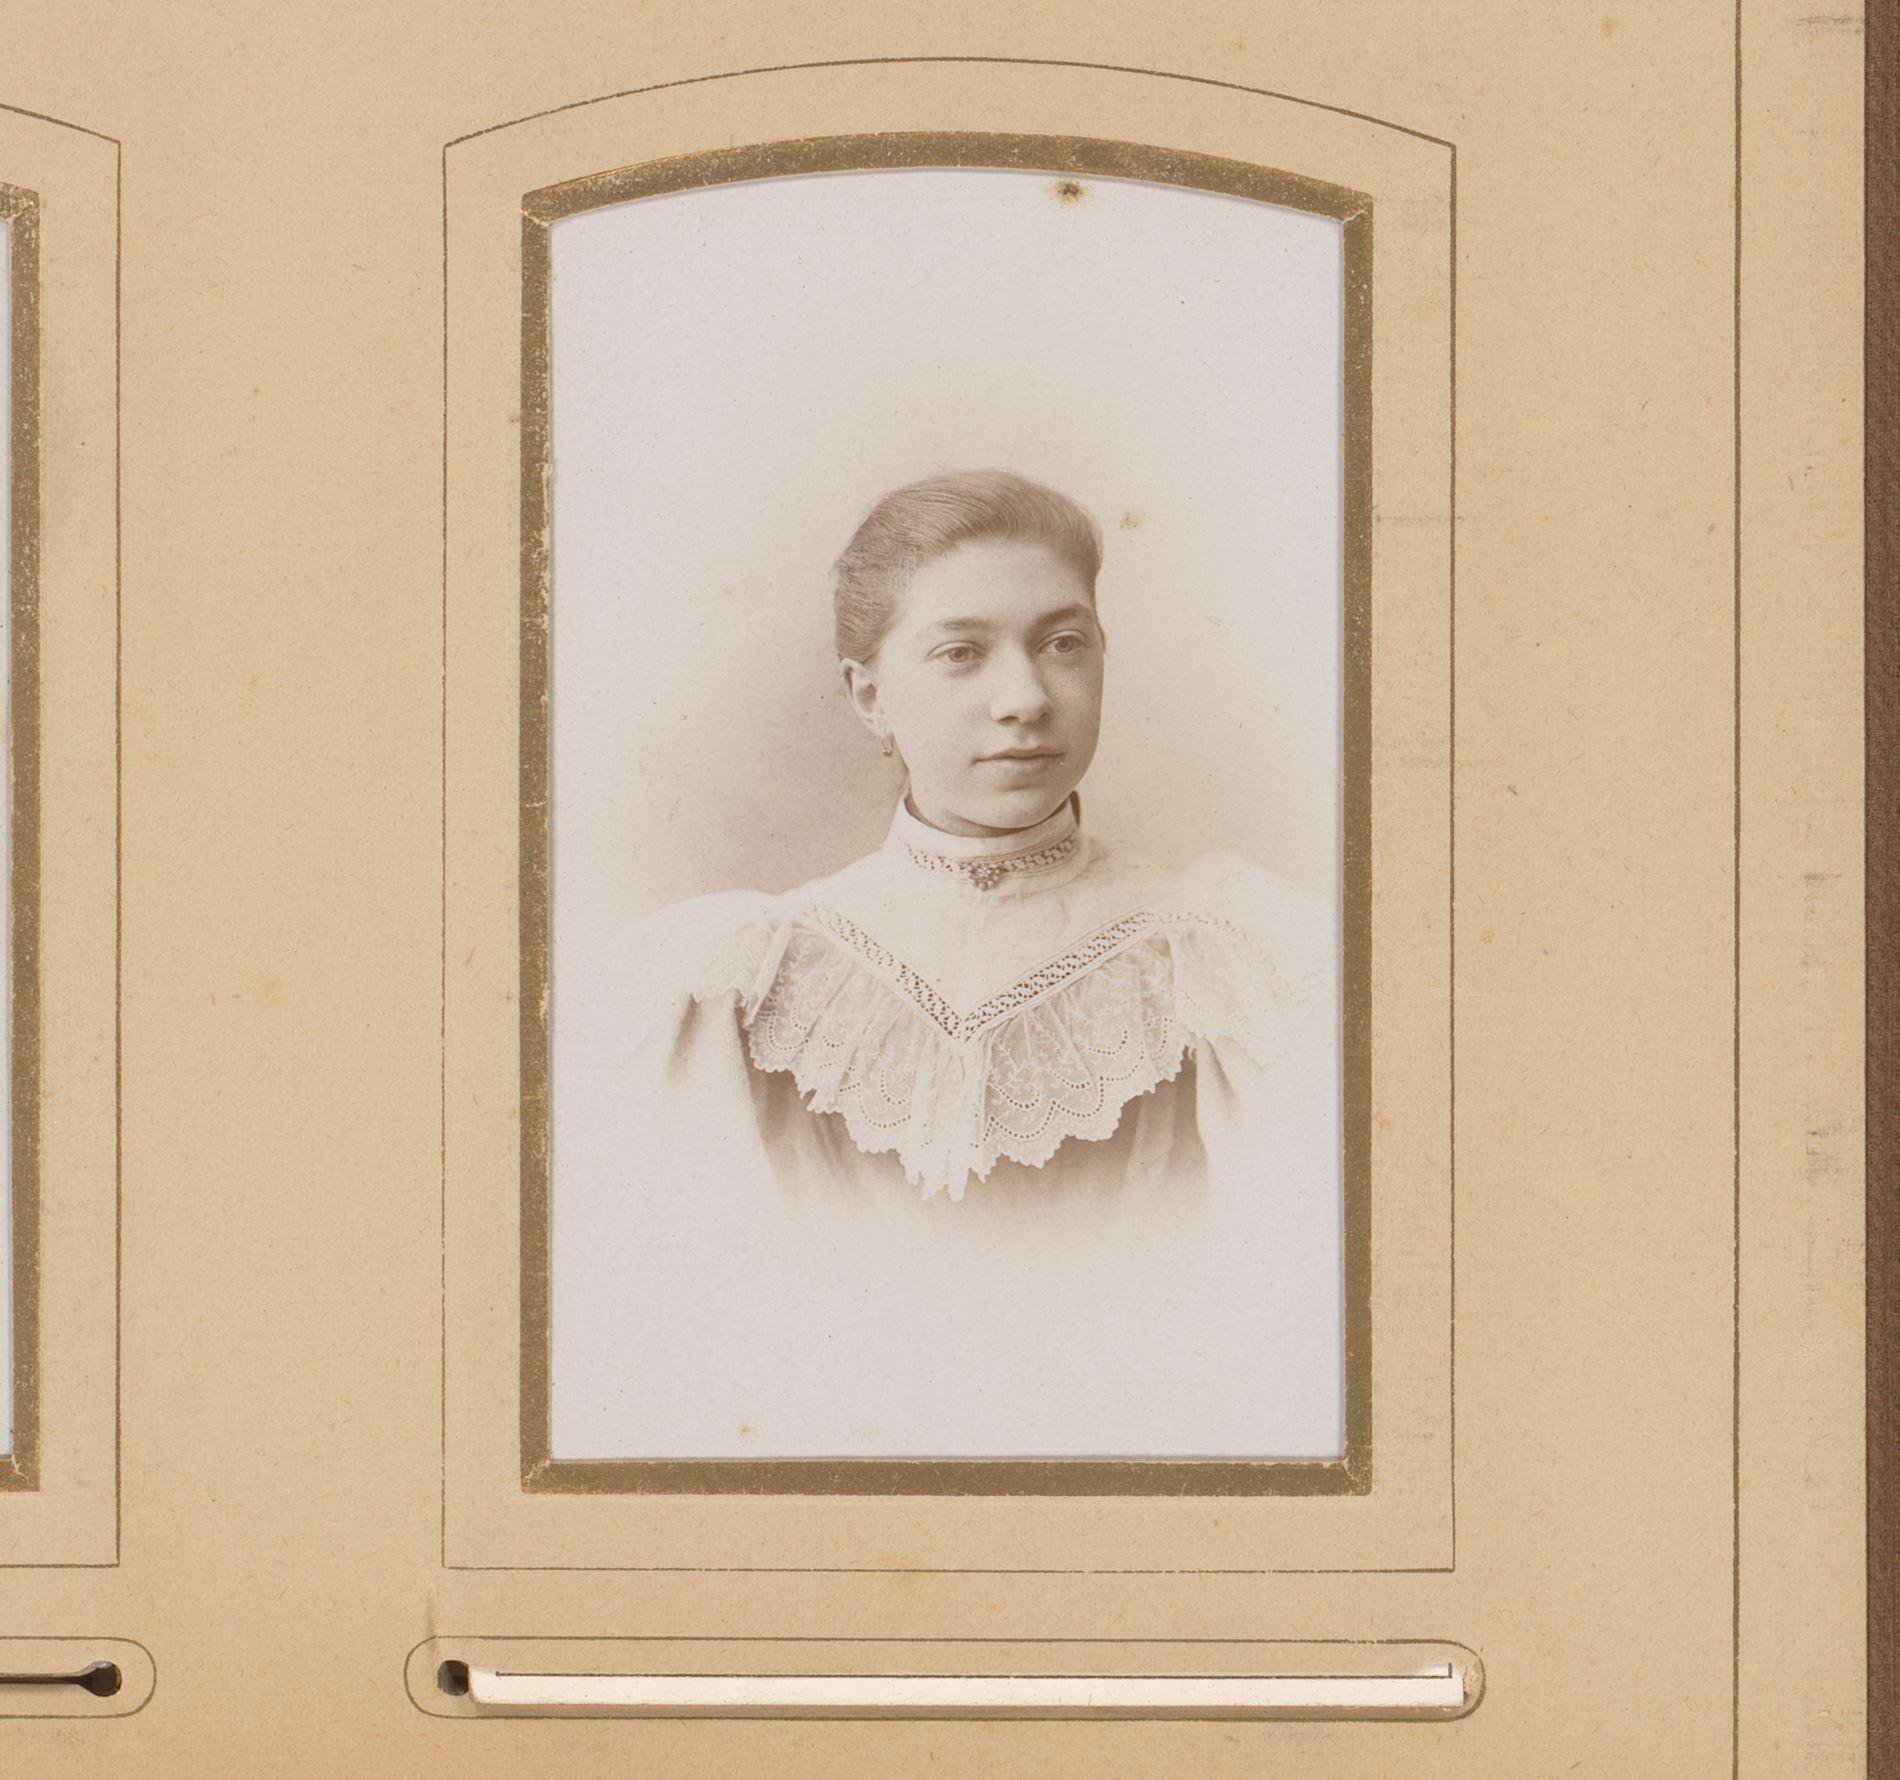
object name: carte de visite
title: Portret van Coba Roos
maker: albert greiner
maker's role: fotograaf, fotostudio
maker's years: 1833-1890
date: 1883-1887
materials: cardboard, photographic support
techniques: collodion silver print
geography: amsterdam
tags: adolescent, young woman, maiden, historical persons - bb - woman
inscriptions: inscription: ‘(...)/ ALBERT GREINER/(...)/ AMSTERDAM/ NIEUWENDIJK 89./ Specialiteit in Vergrootingen.’, name: ‘Tante Coba Roos’